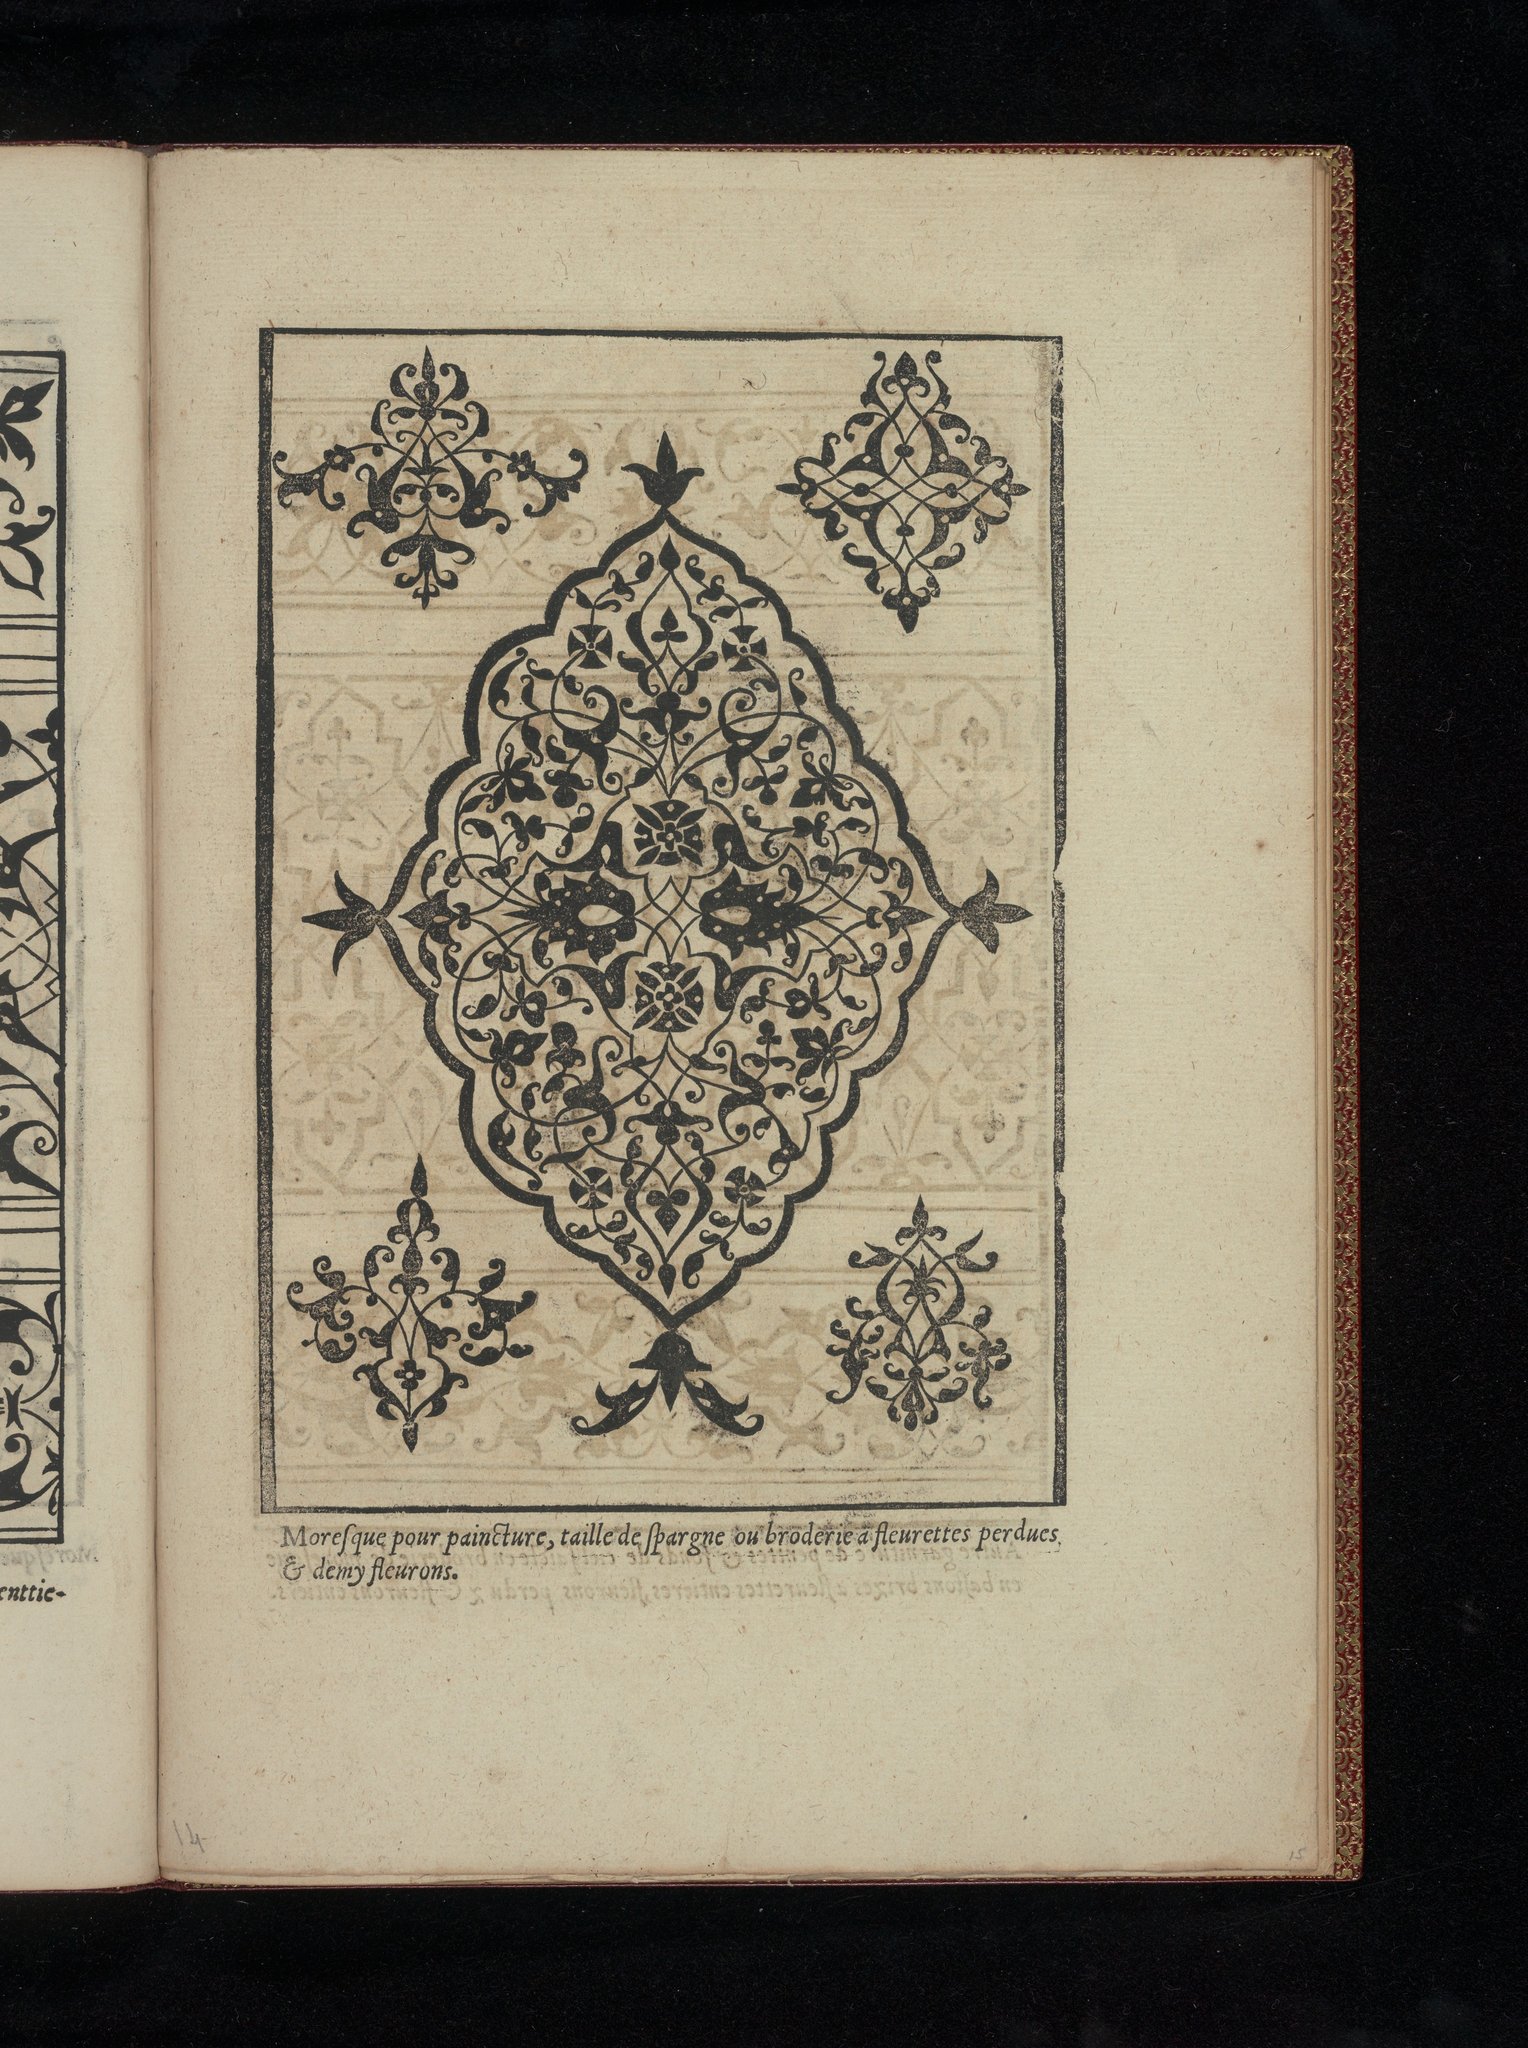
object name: book print ornament architecture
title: Livre de Moresques, page 15 (recto)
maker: francesco di pellegrino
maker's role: artist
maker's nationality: italian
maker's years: 1525-1552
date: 1546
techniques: woodcut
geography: france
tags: ornament